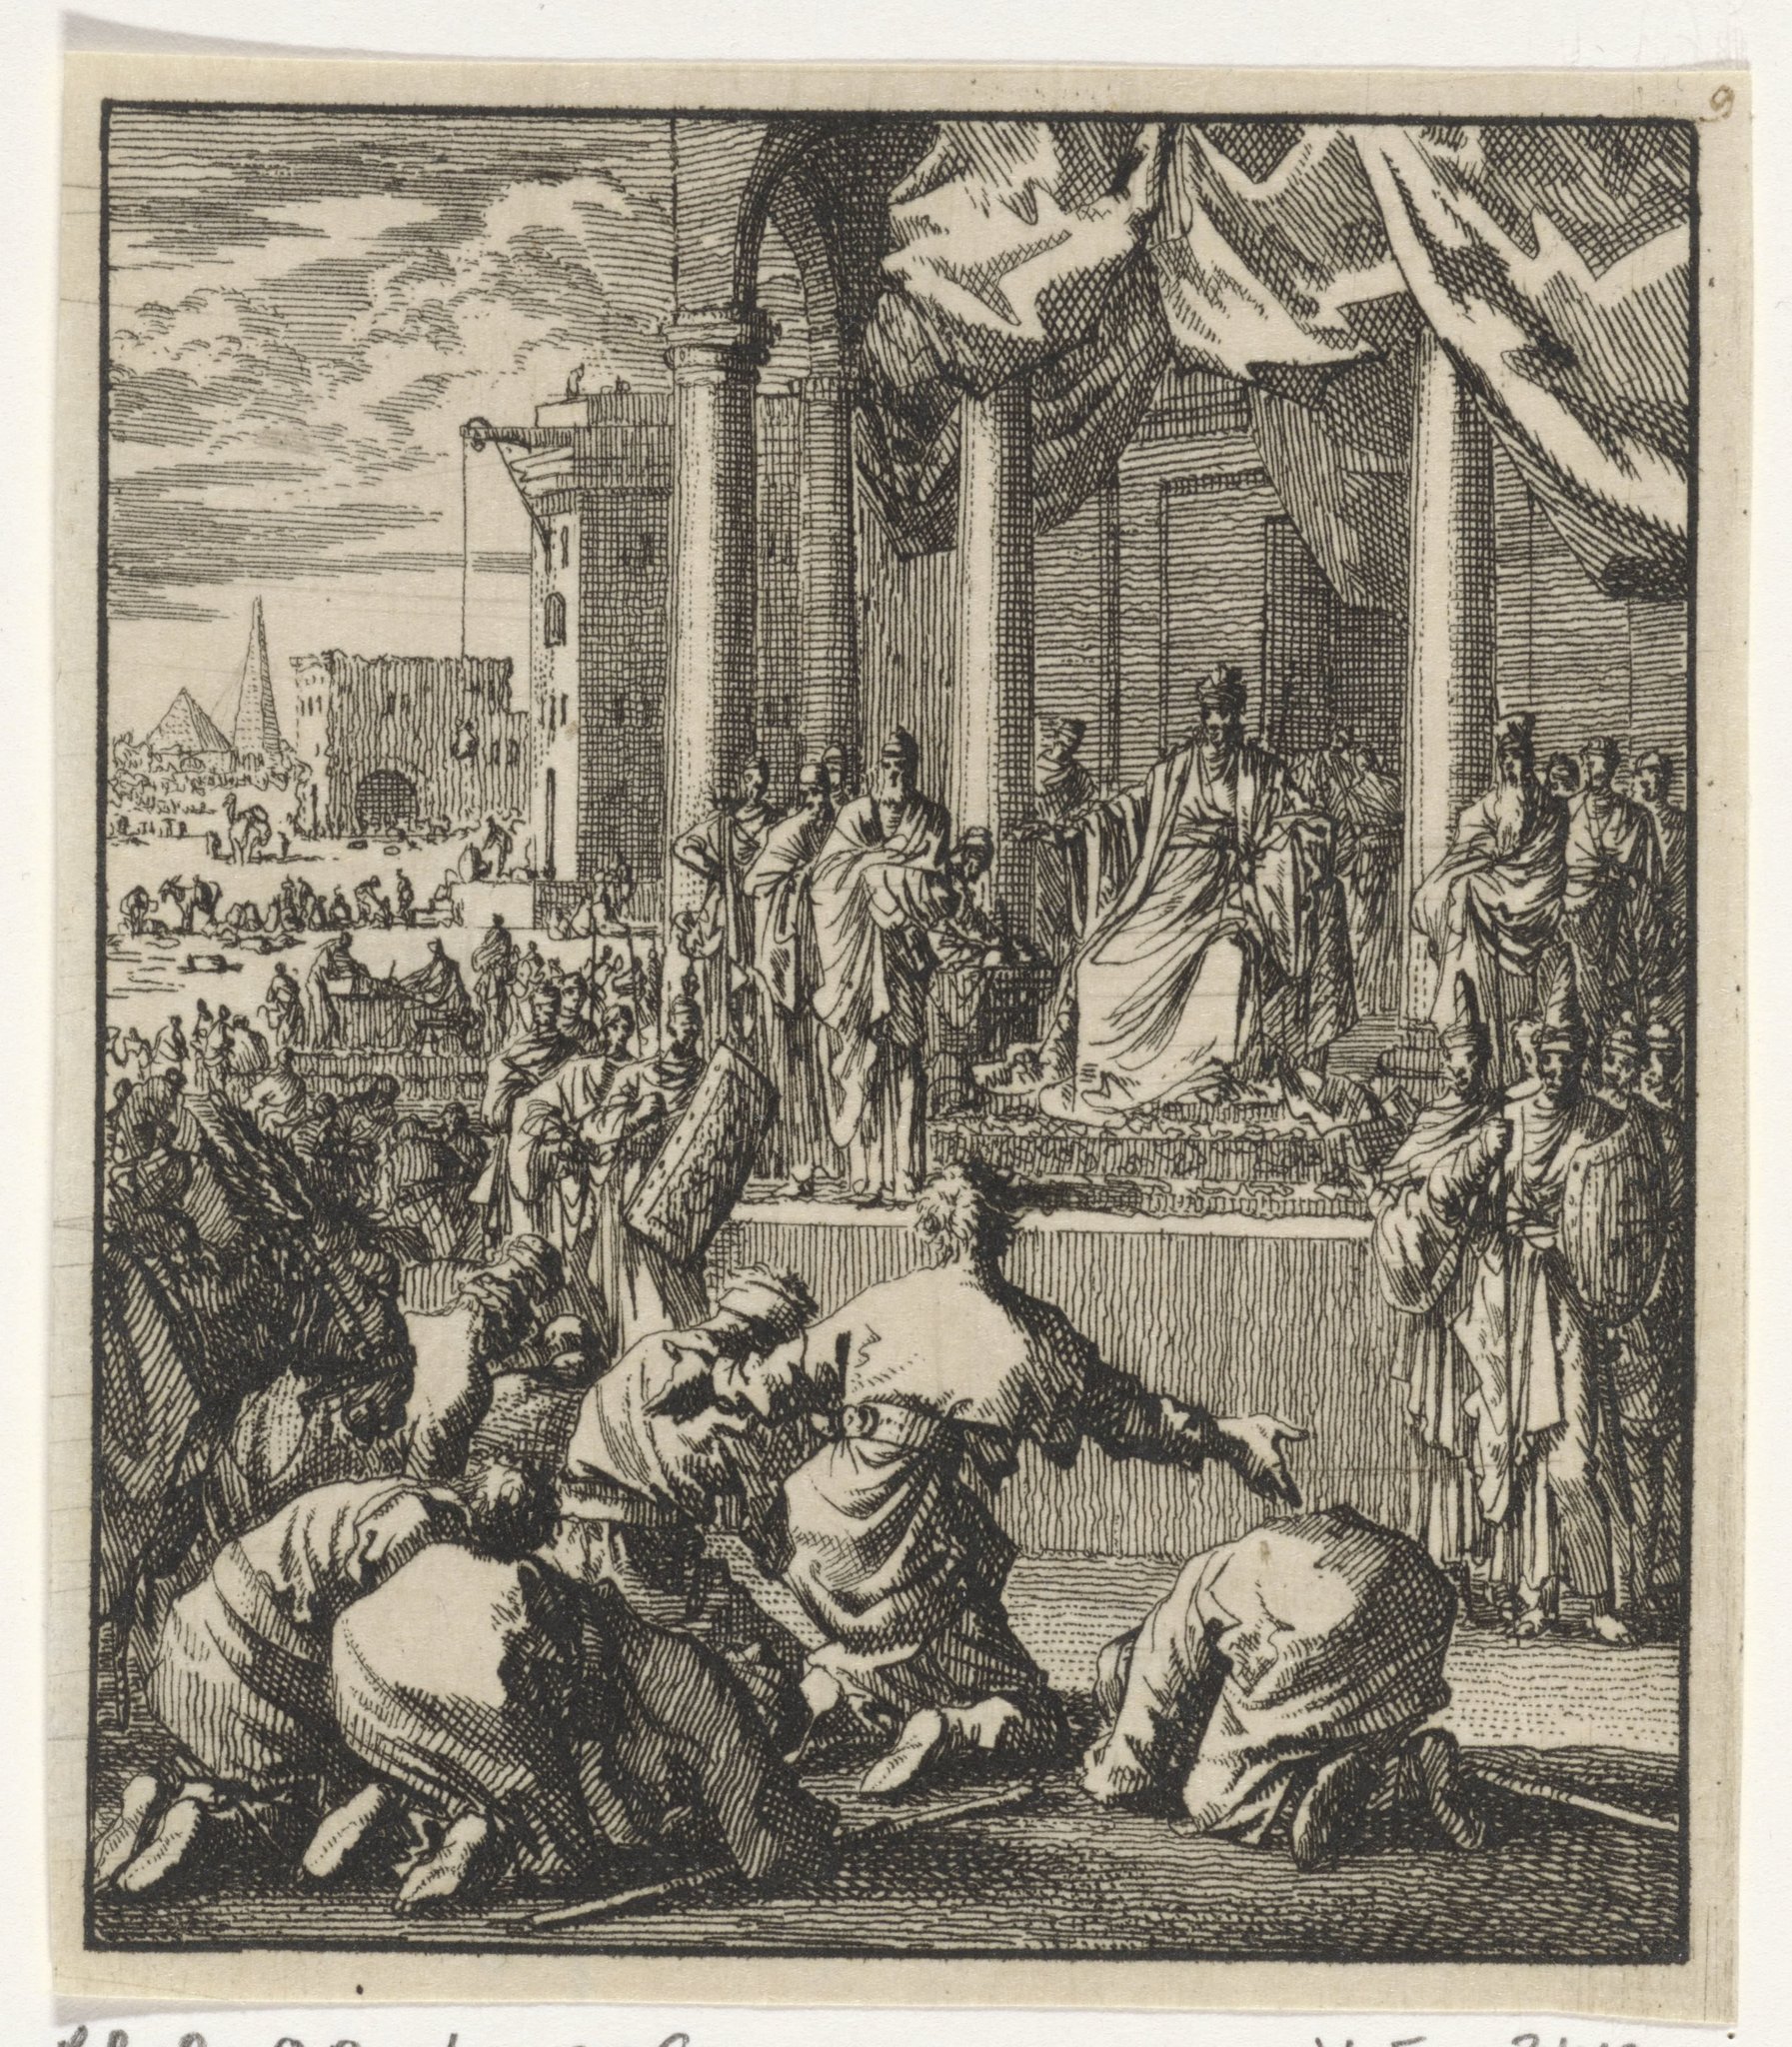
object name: print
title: Zonen van Jakob knielen voor Jozef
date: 1706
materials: paper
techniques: etching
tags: further story of jacob's sons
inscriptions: collector's mark: Lugt 2228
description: Illustratie voor: Schabaalje, Jean Philipsz. De vermeerderde lust-hof des gemoeds. Amsterdam: Jan Rieuwertsz. (II) en Barent Visscher, 1706, p. 187.